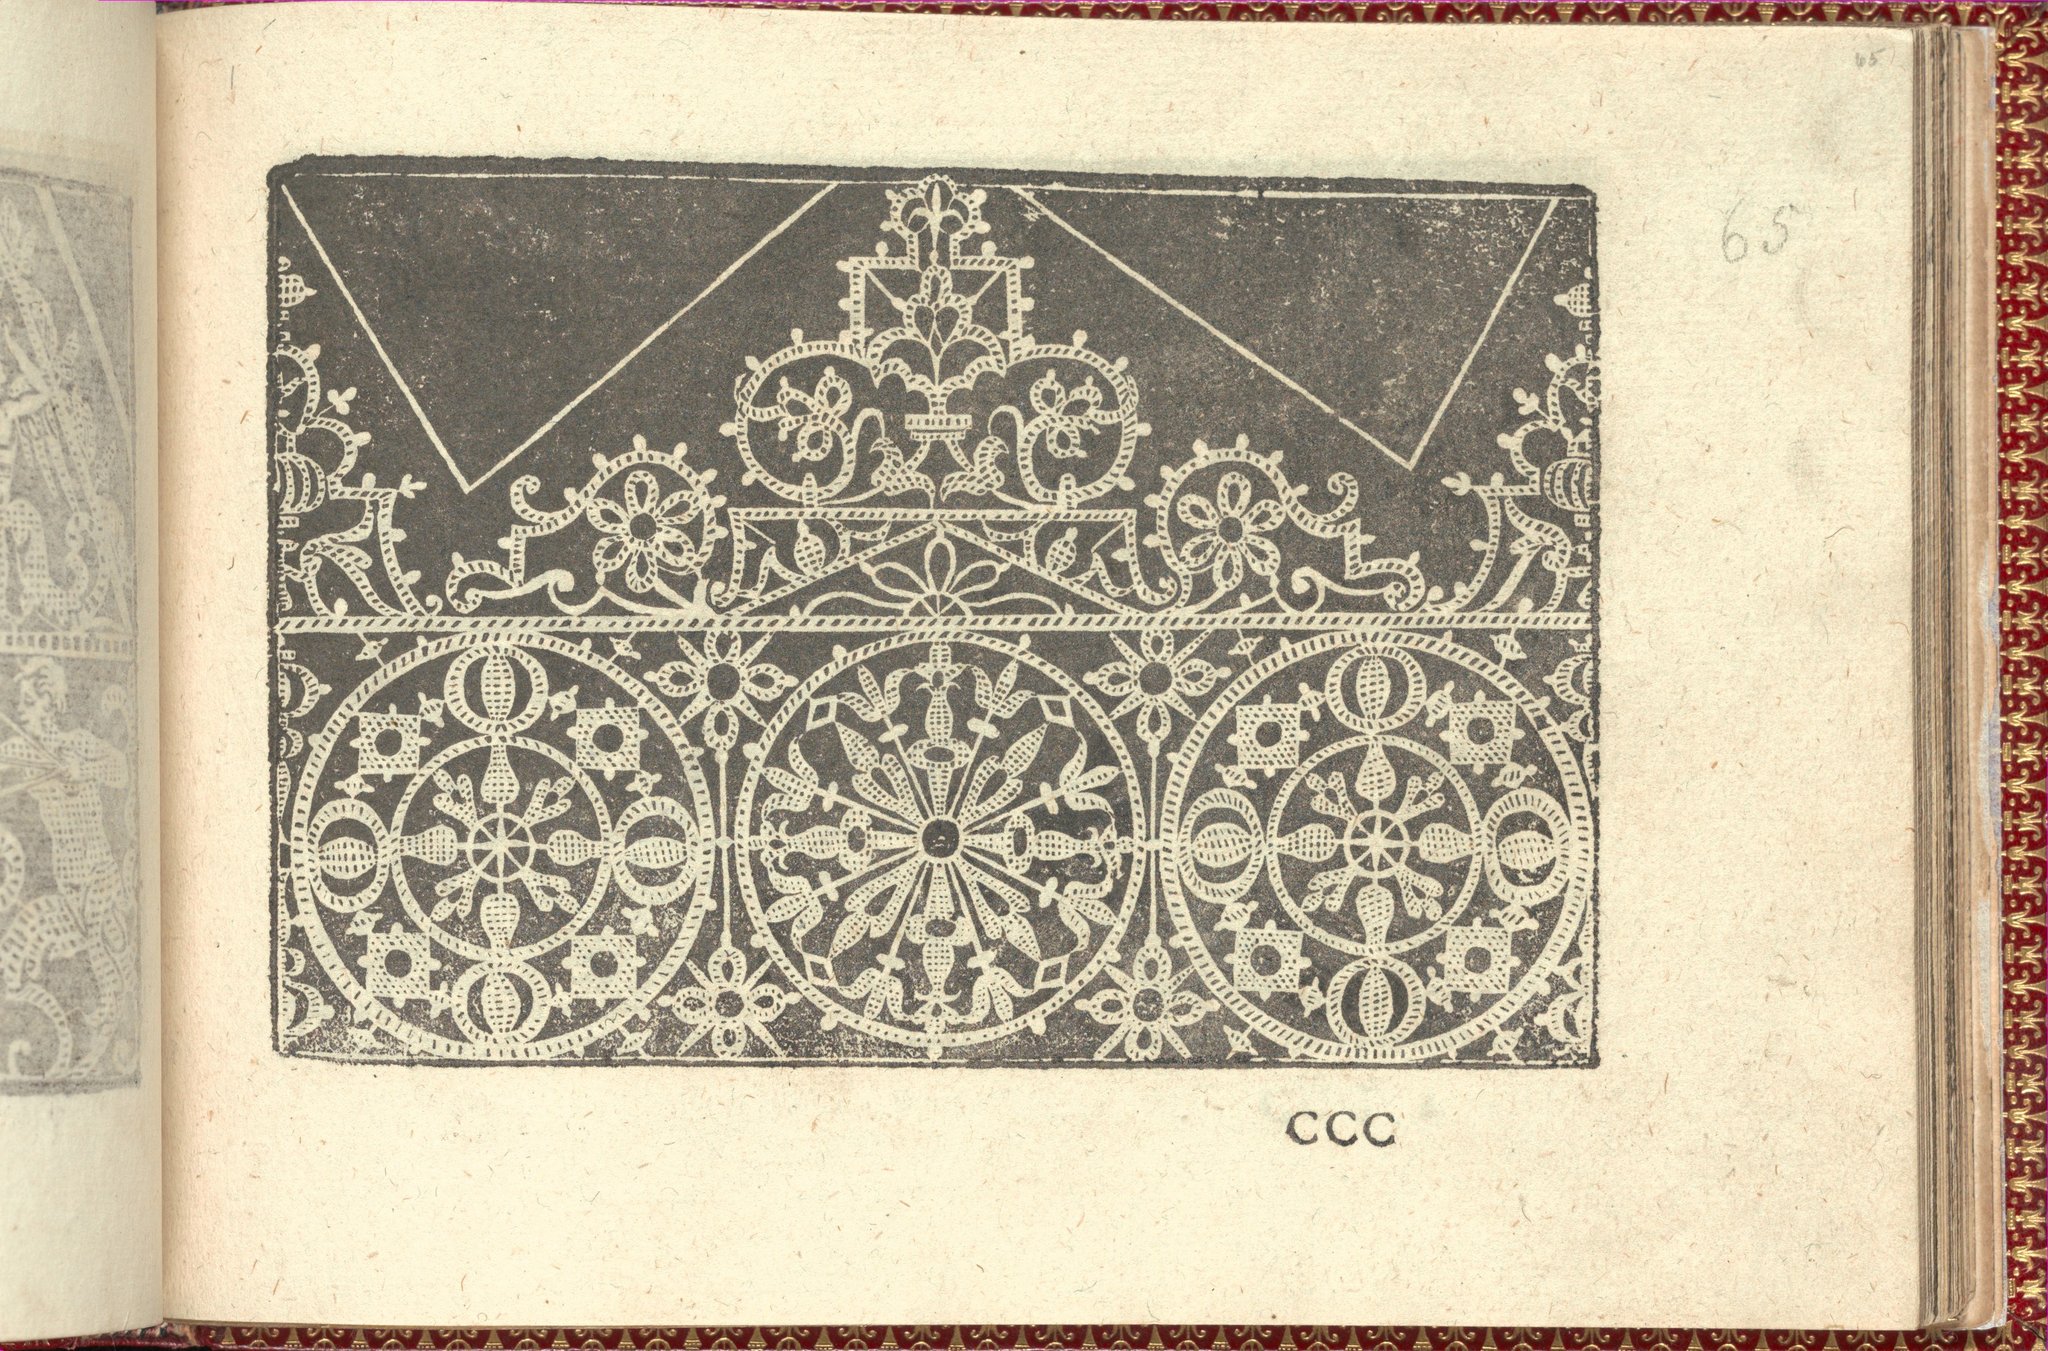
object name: book print ornament architecture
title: Corona delle Nobili et Virtuose Donne: Libro I-IV, page 65 (recto)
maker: cesare vecellio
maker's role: publisher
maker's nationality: italian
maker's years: 1521-1601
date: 1601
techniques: woodcut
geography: italy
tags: ornament